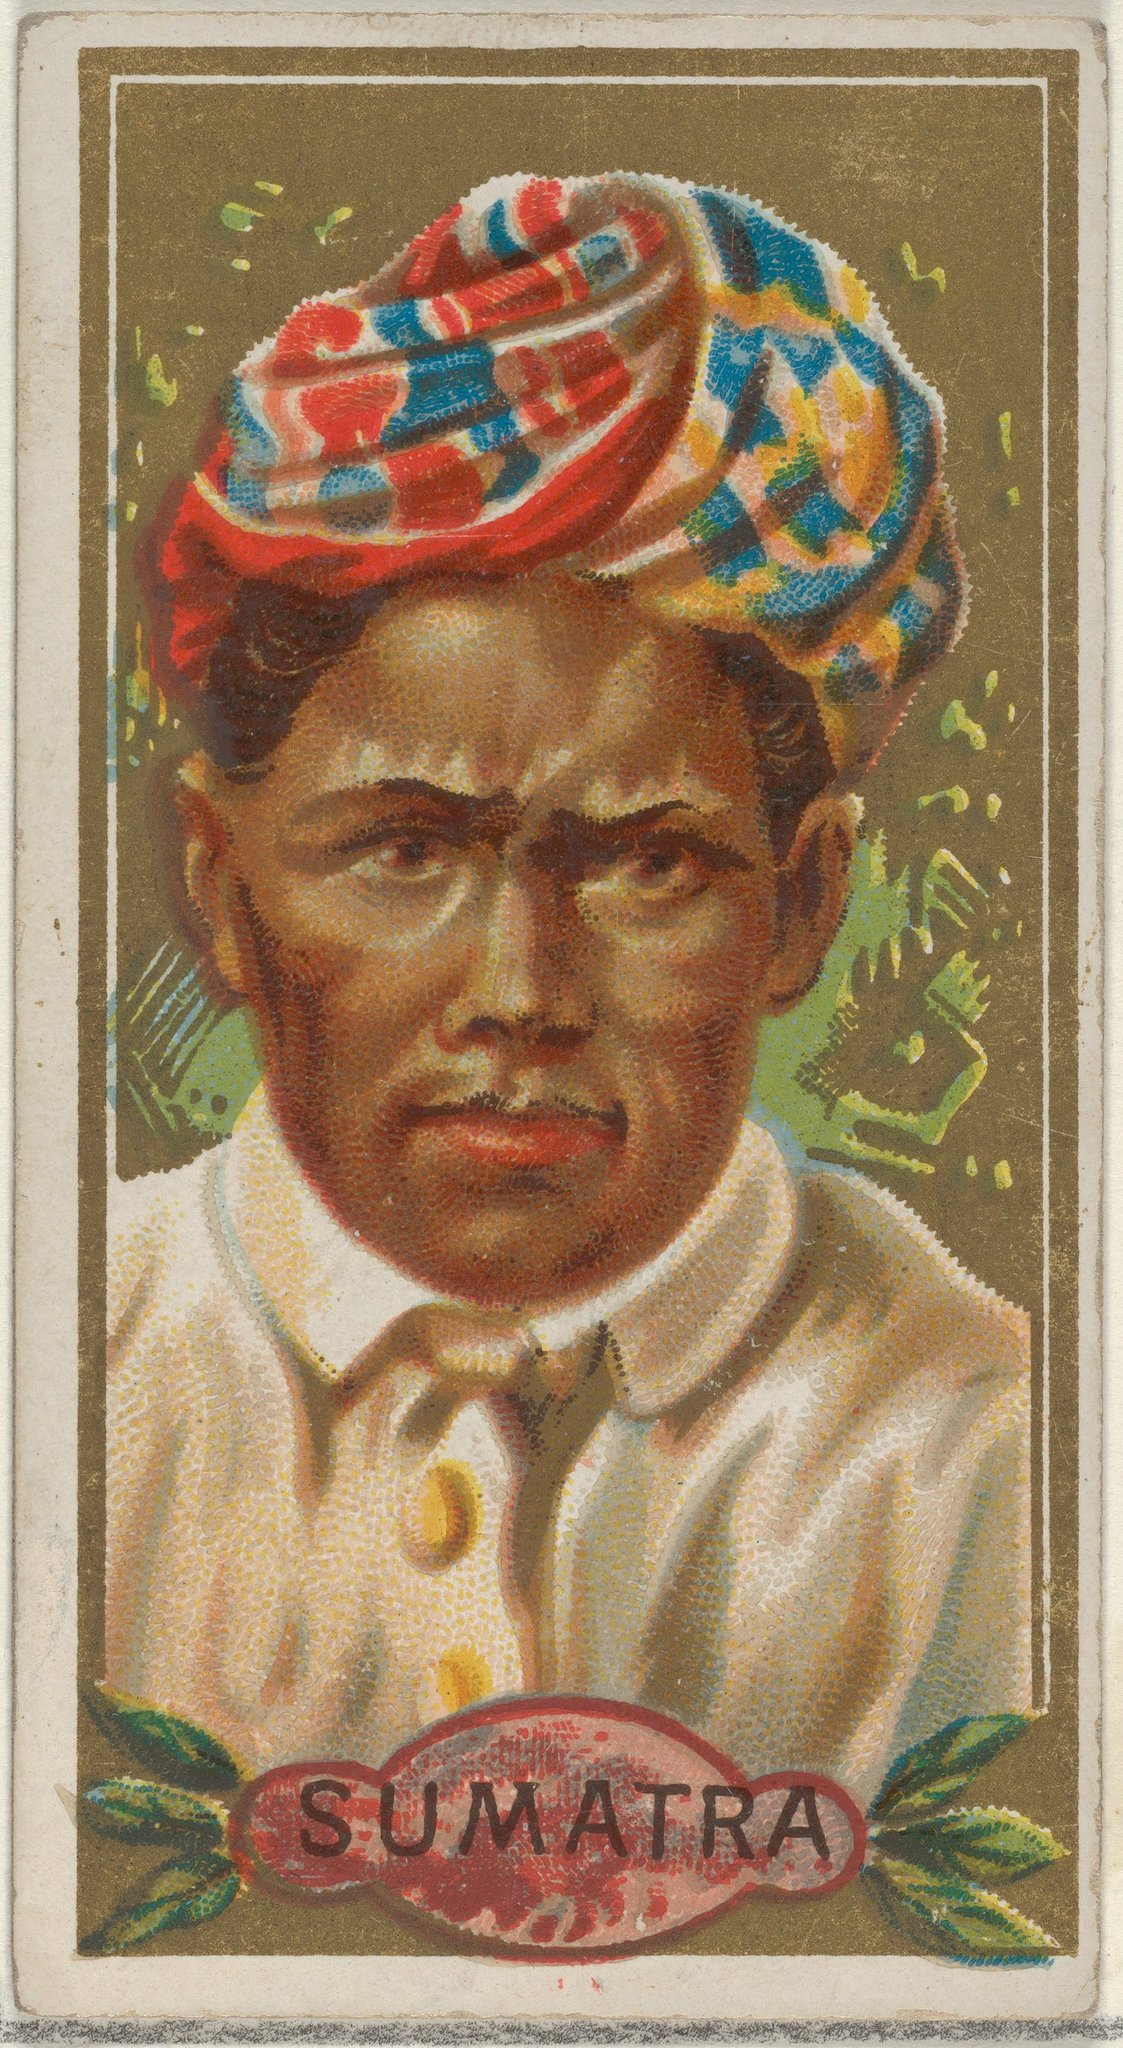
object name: print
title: Sumatra, from the Types of All Nations series (N24) for Allen & Ginter Cigarettes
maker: allen & ginter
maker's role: publisher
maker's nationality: american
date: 1889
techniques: color lithograph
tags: men